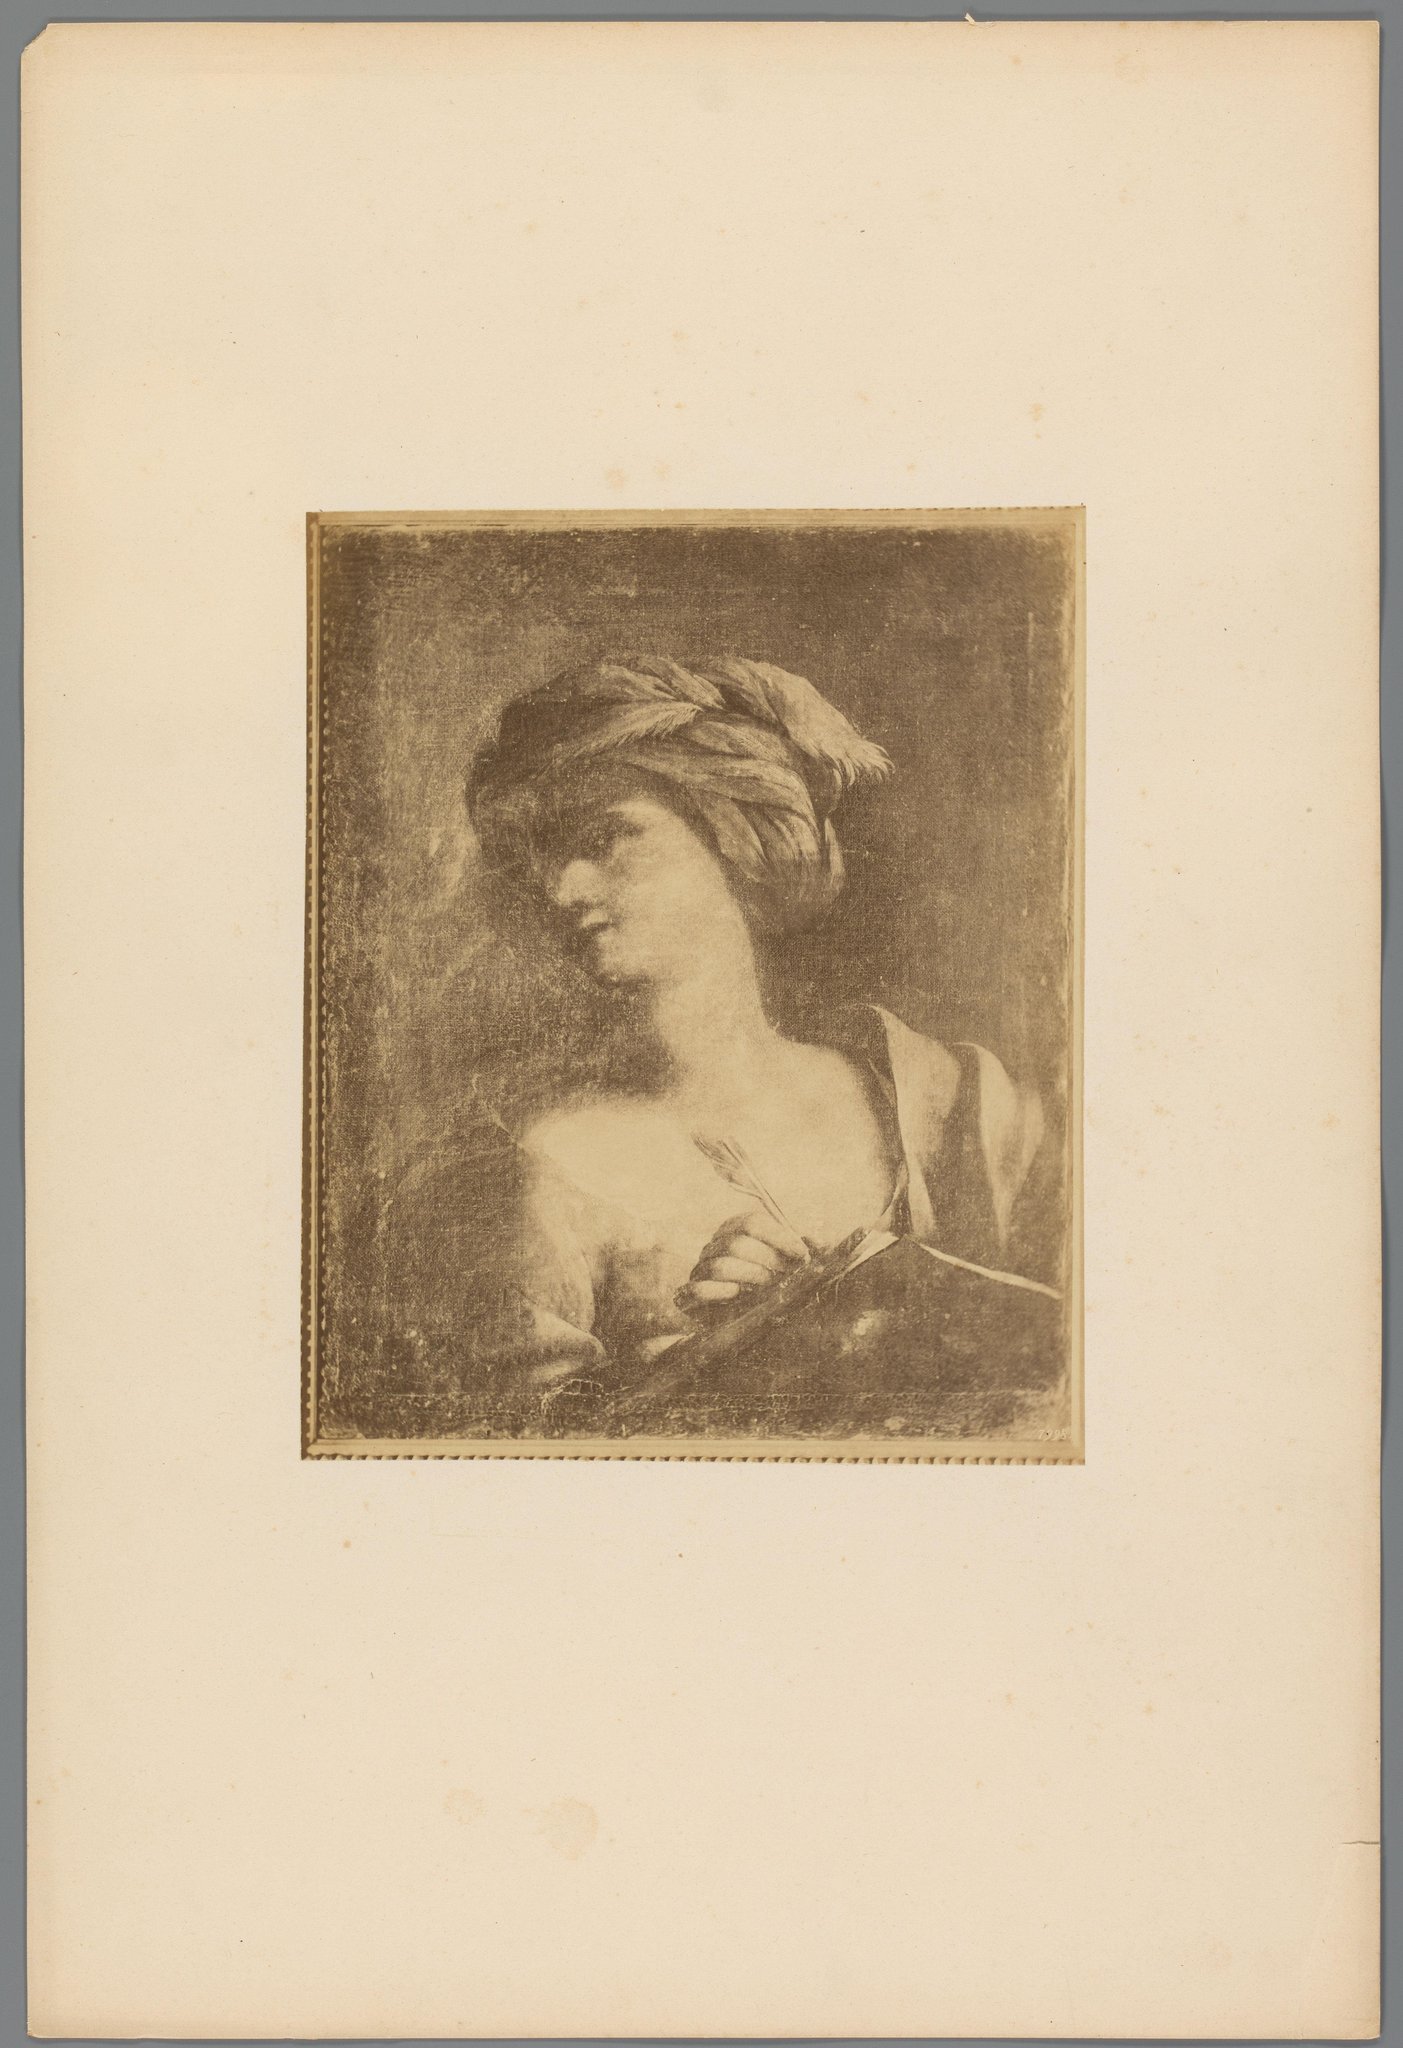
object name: photograph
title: Fotoreproductie van een schilderij voorstellende een jongen met een ganzenveer in zijn hand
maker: Anonymous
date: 1851-1900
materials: cardboard, paper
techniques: albumen print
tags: picture, painting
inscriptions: number: ‘7998.’